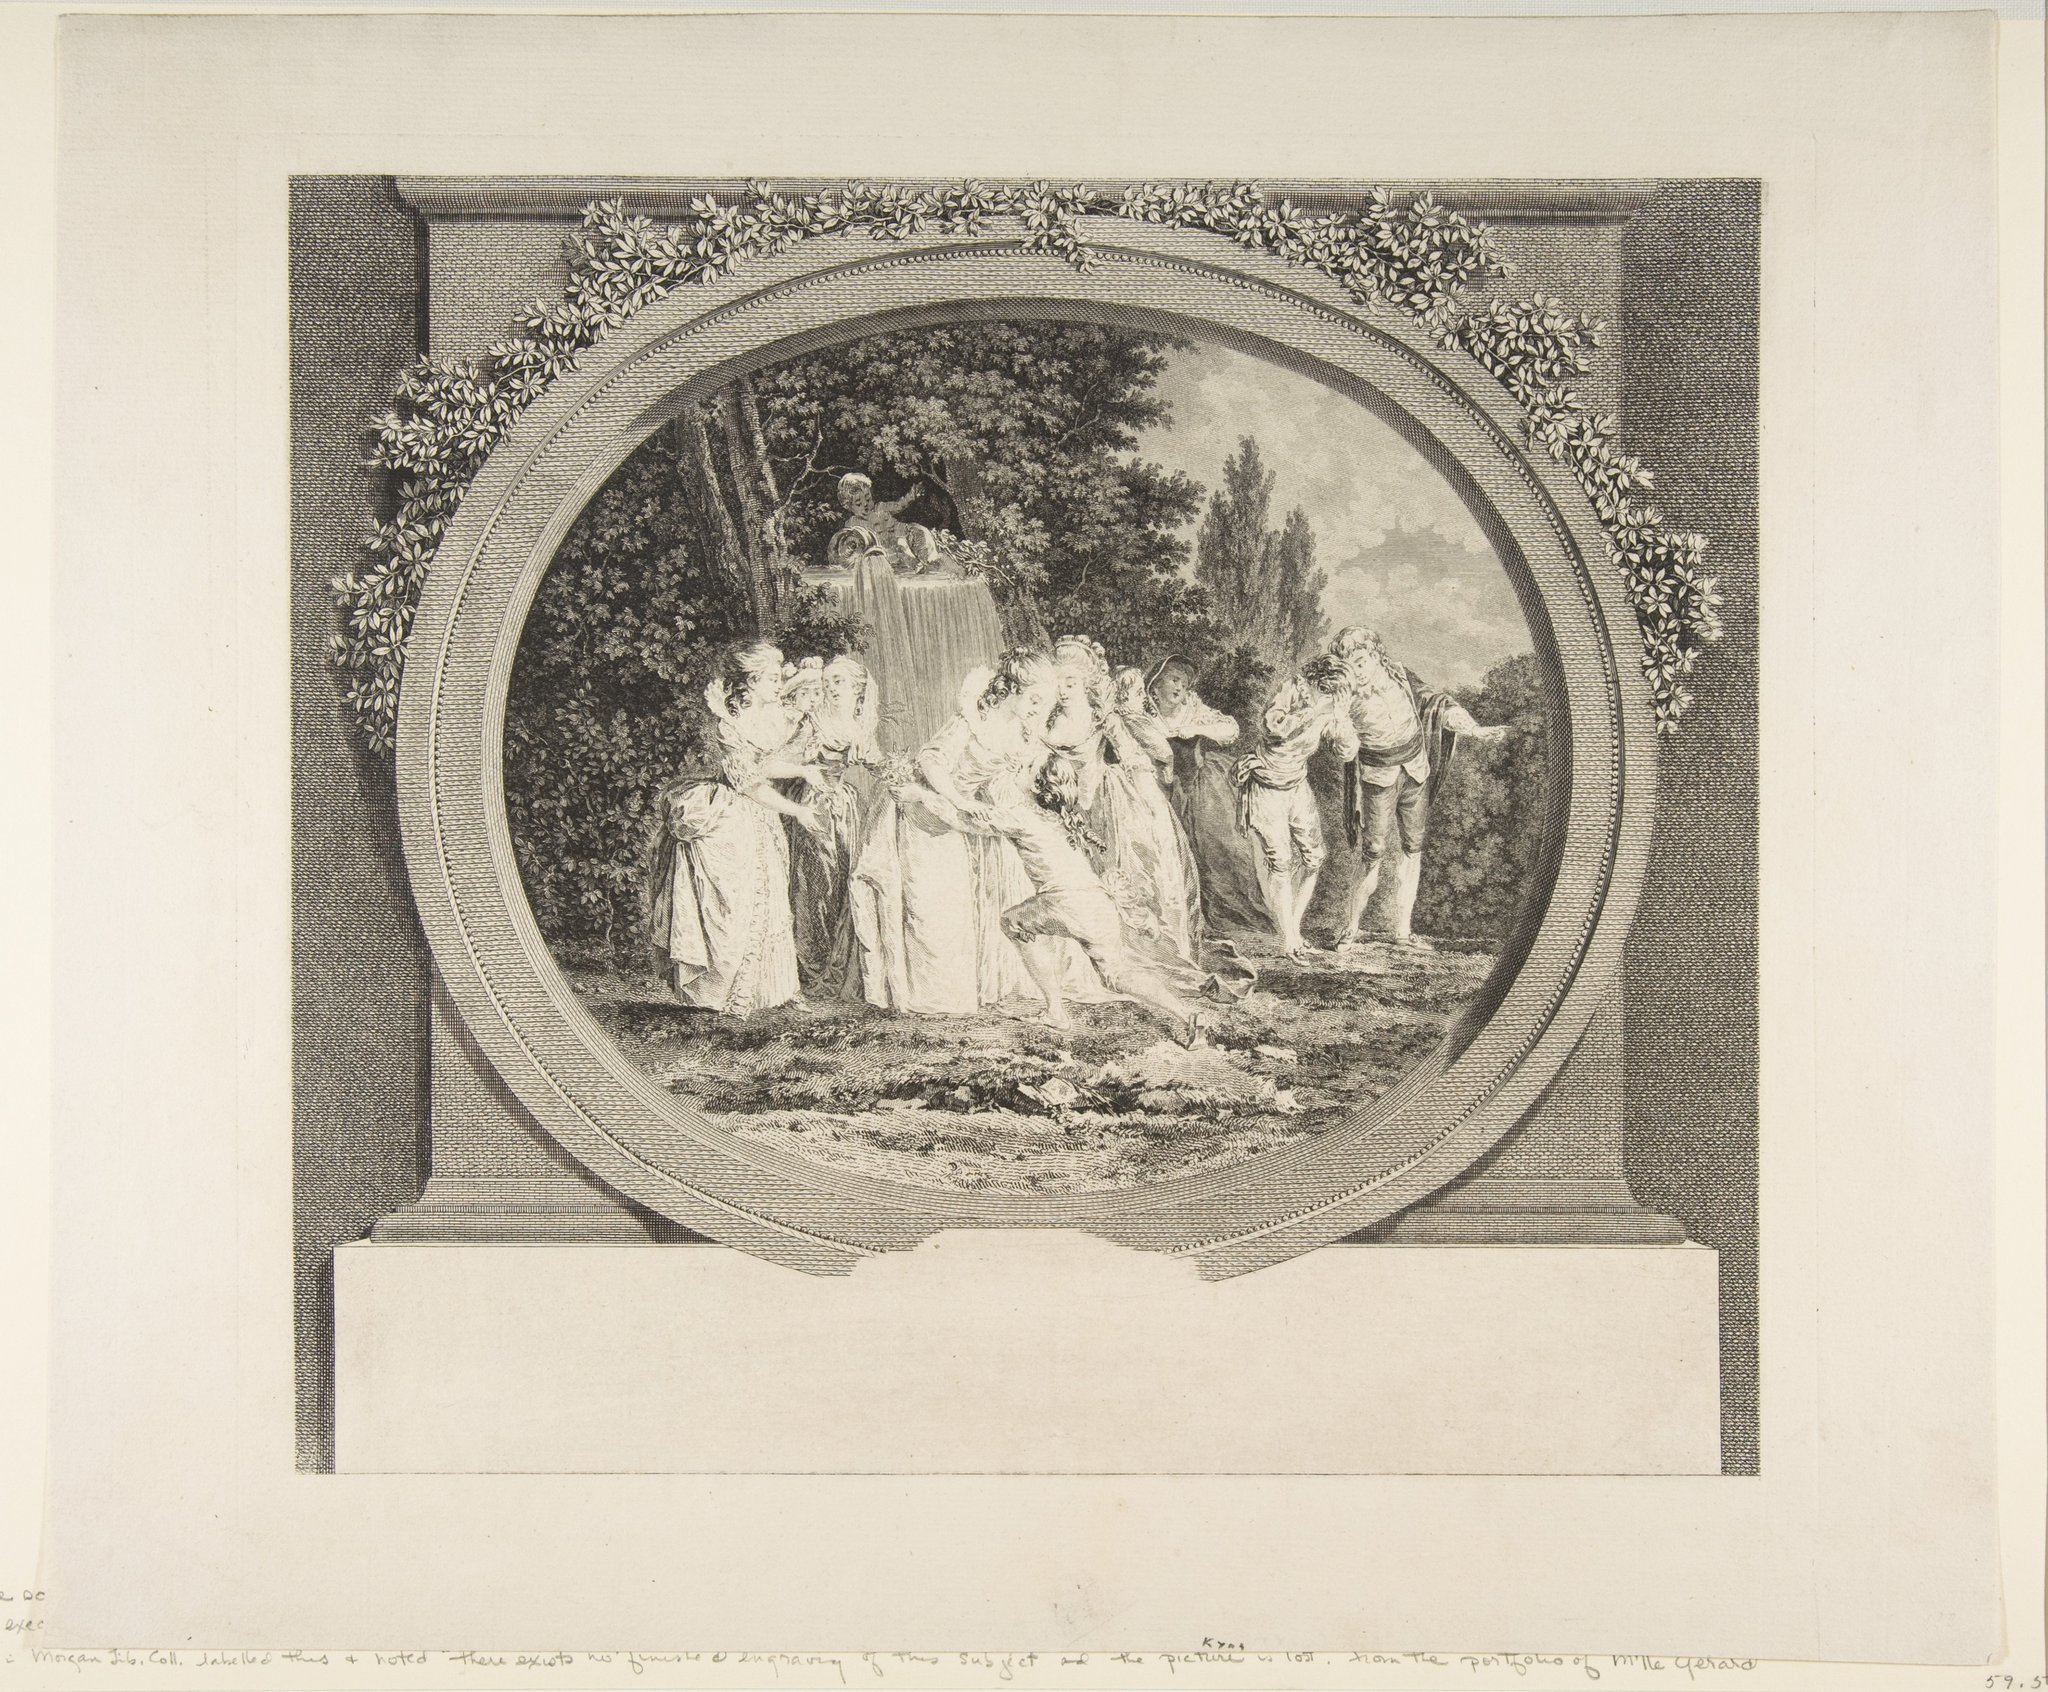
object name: print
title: Jeu de Societe dans un Parc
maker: jean honoré fragonard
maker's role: artist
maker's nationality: french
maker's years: 1732-1806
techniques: etching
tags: parks,boys,girls,women,playing